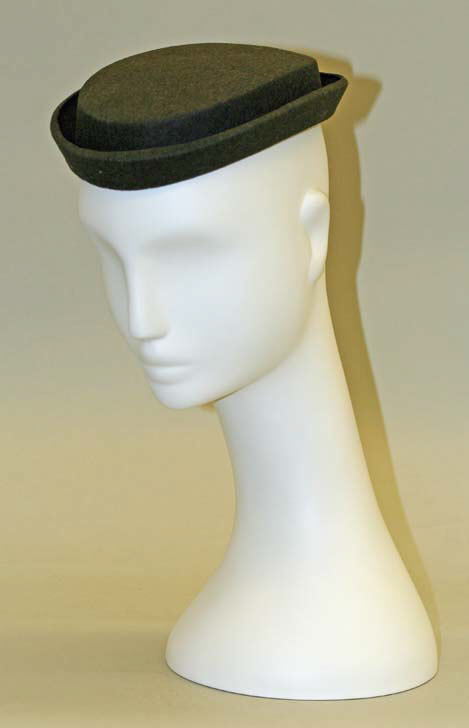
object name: hat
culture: american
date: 1867-1873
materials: wool